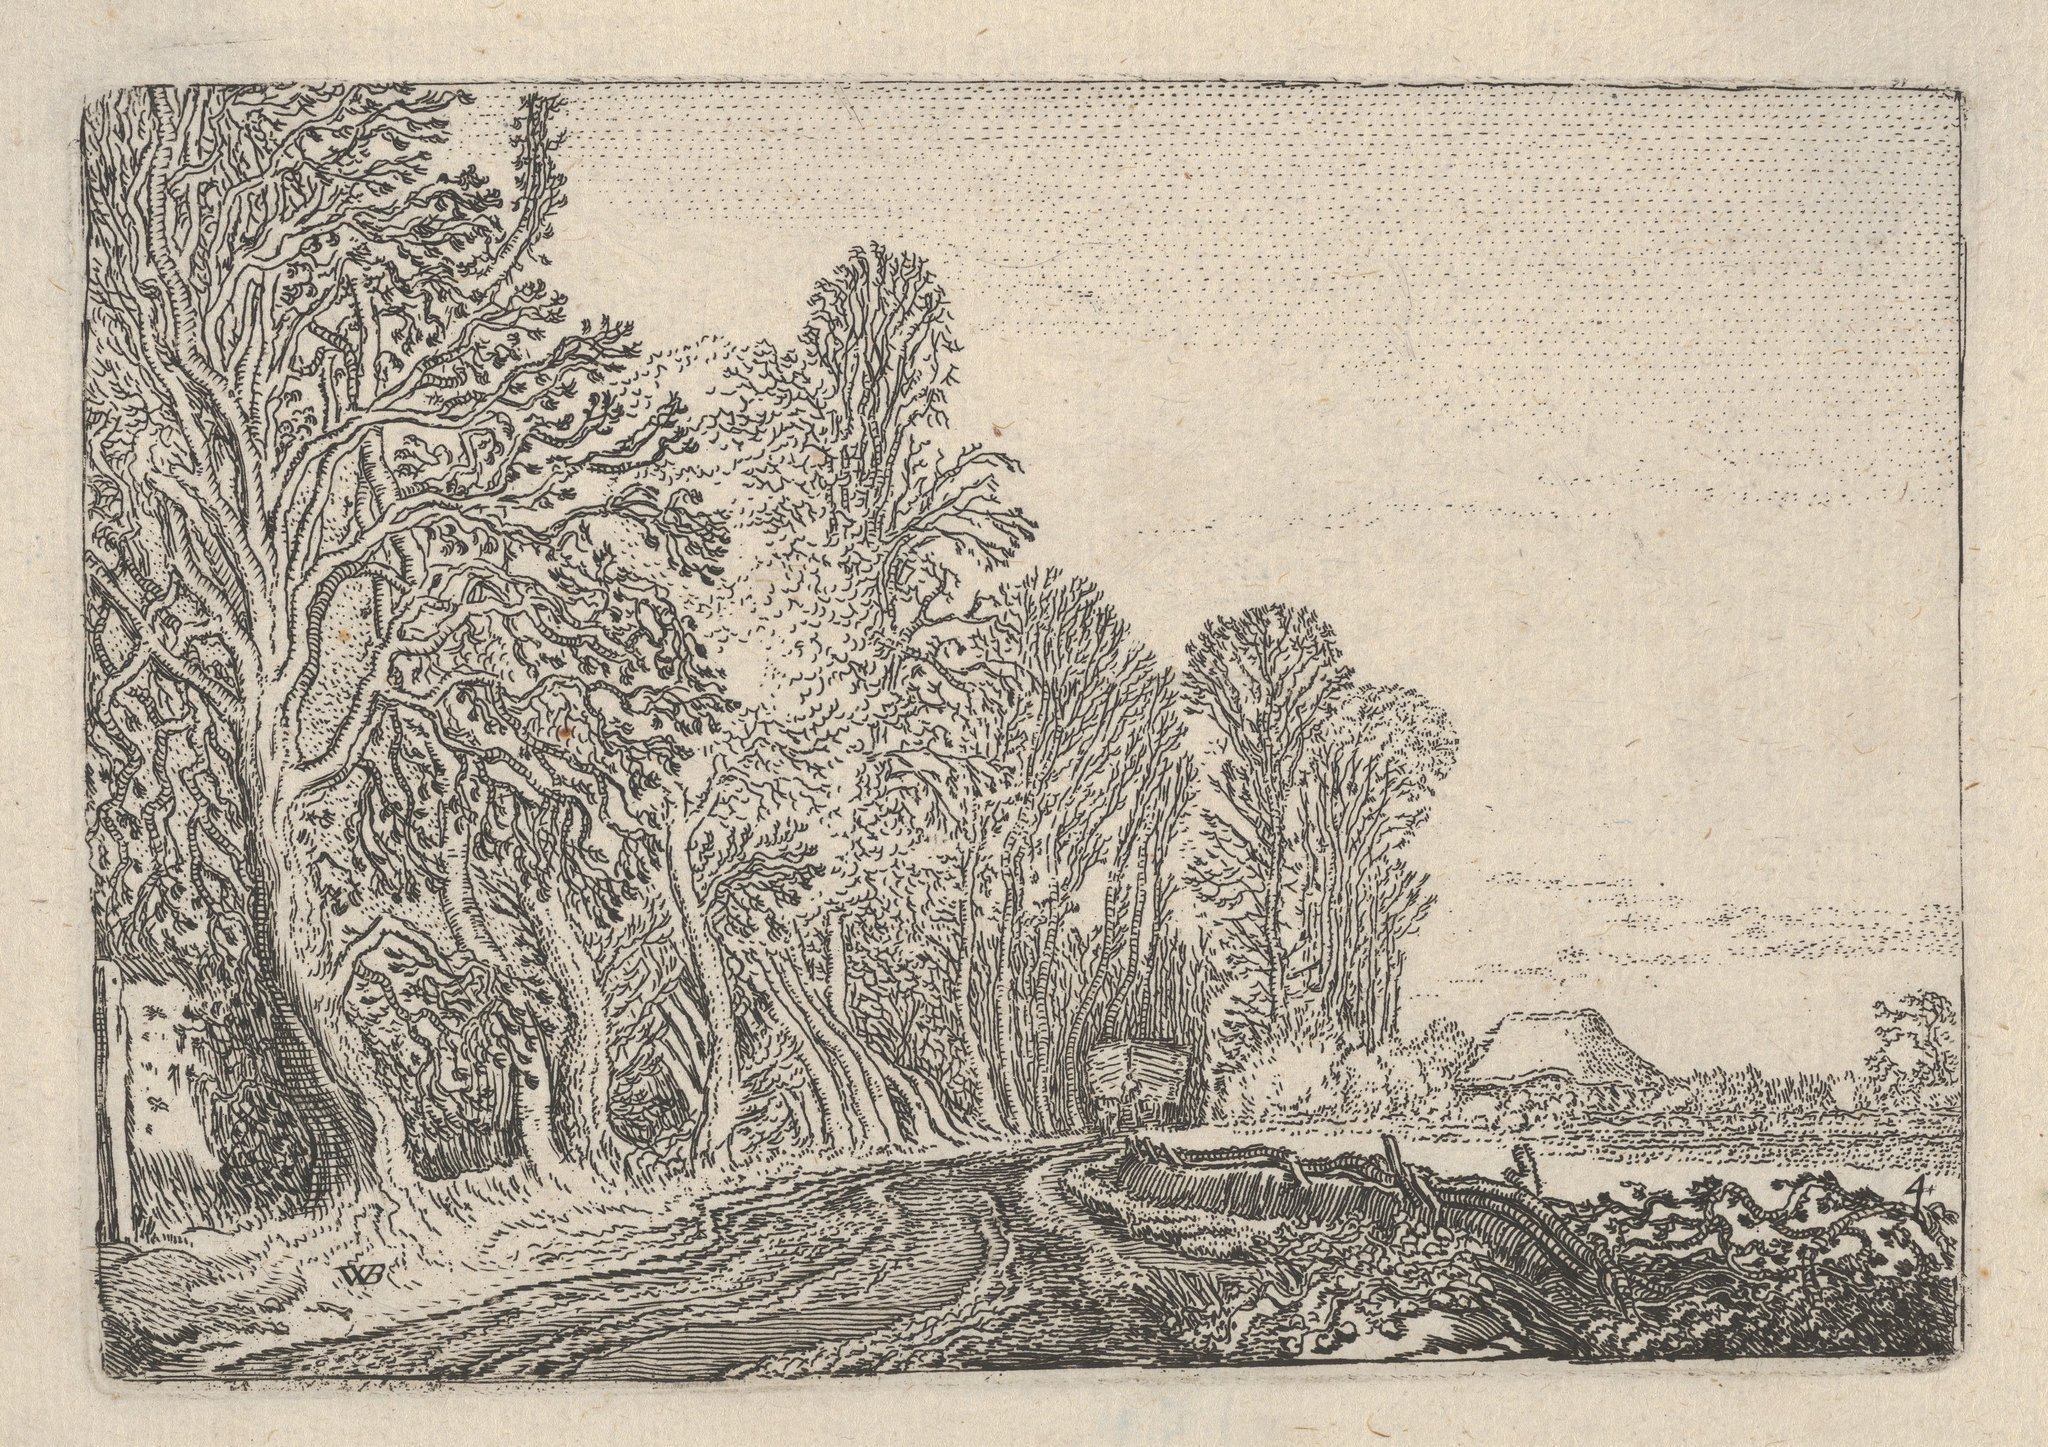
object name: print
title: The Road at the Edge of the Forest, from Verscheyden Landtschapjes (Various Little Landscapes), Plate 4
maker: willem pietersz buytewech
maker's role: artist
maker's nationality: dutch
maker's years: 1591-1624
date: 1616-1617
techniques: etching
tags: roads,forests,landscapes